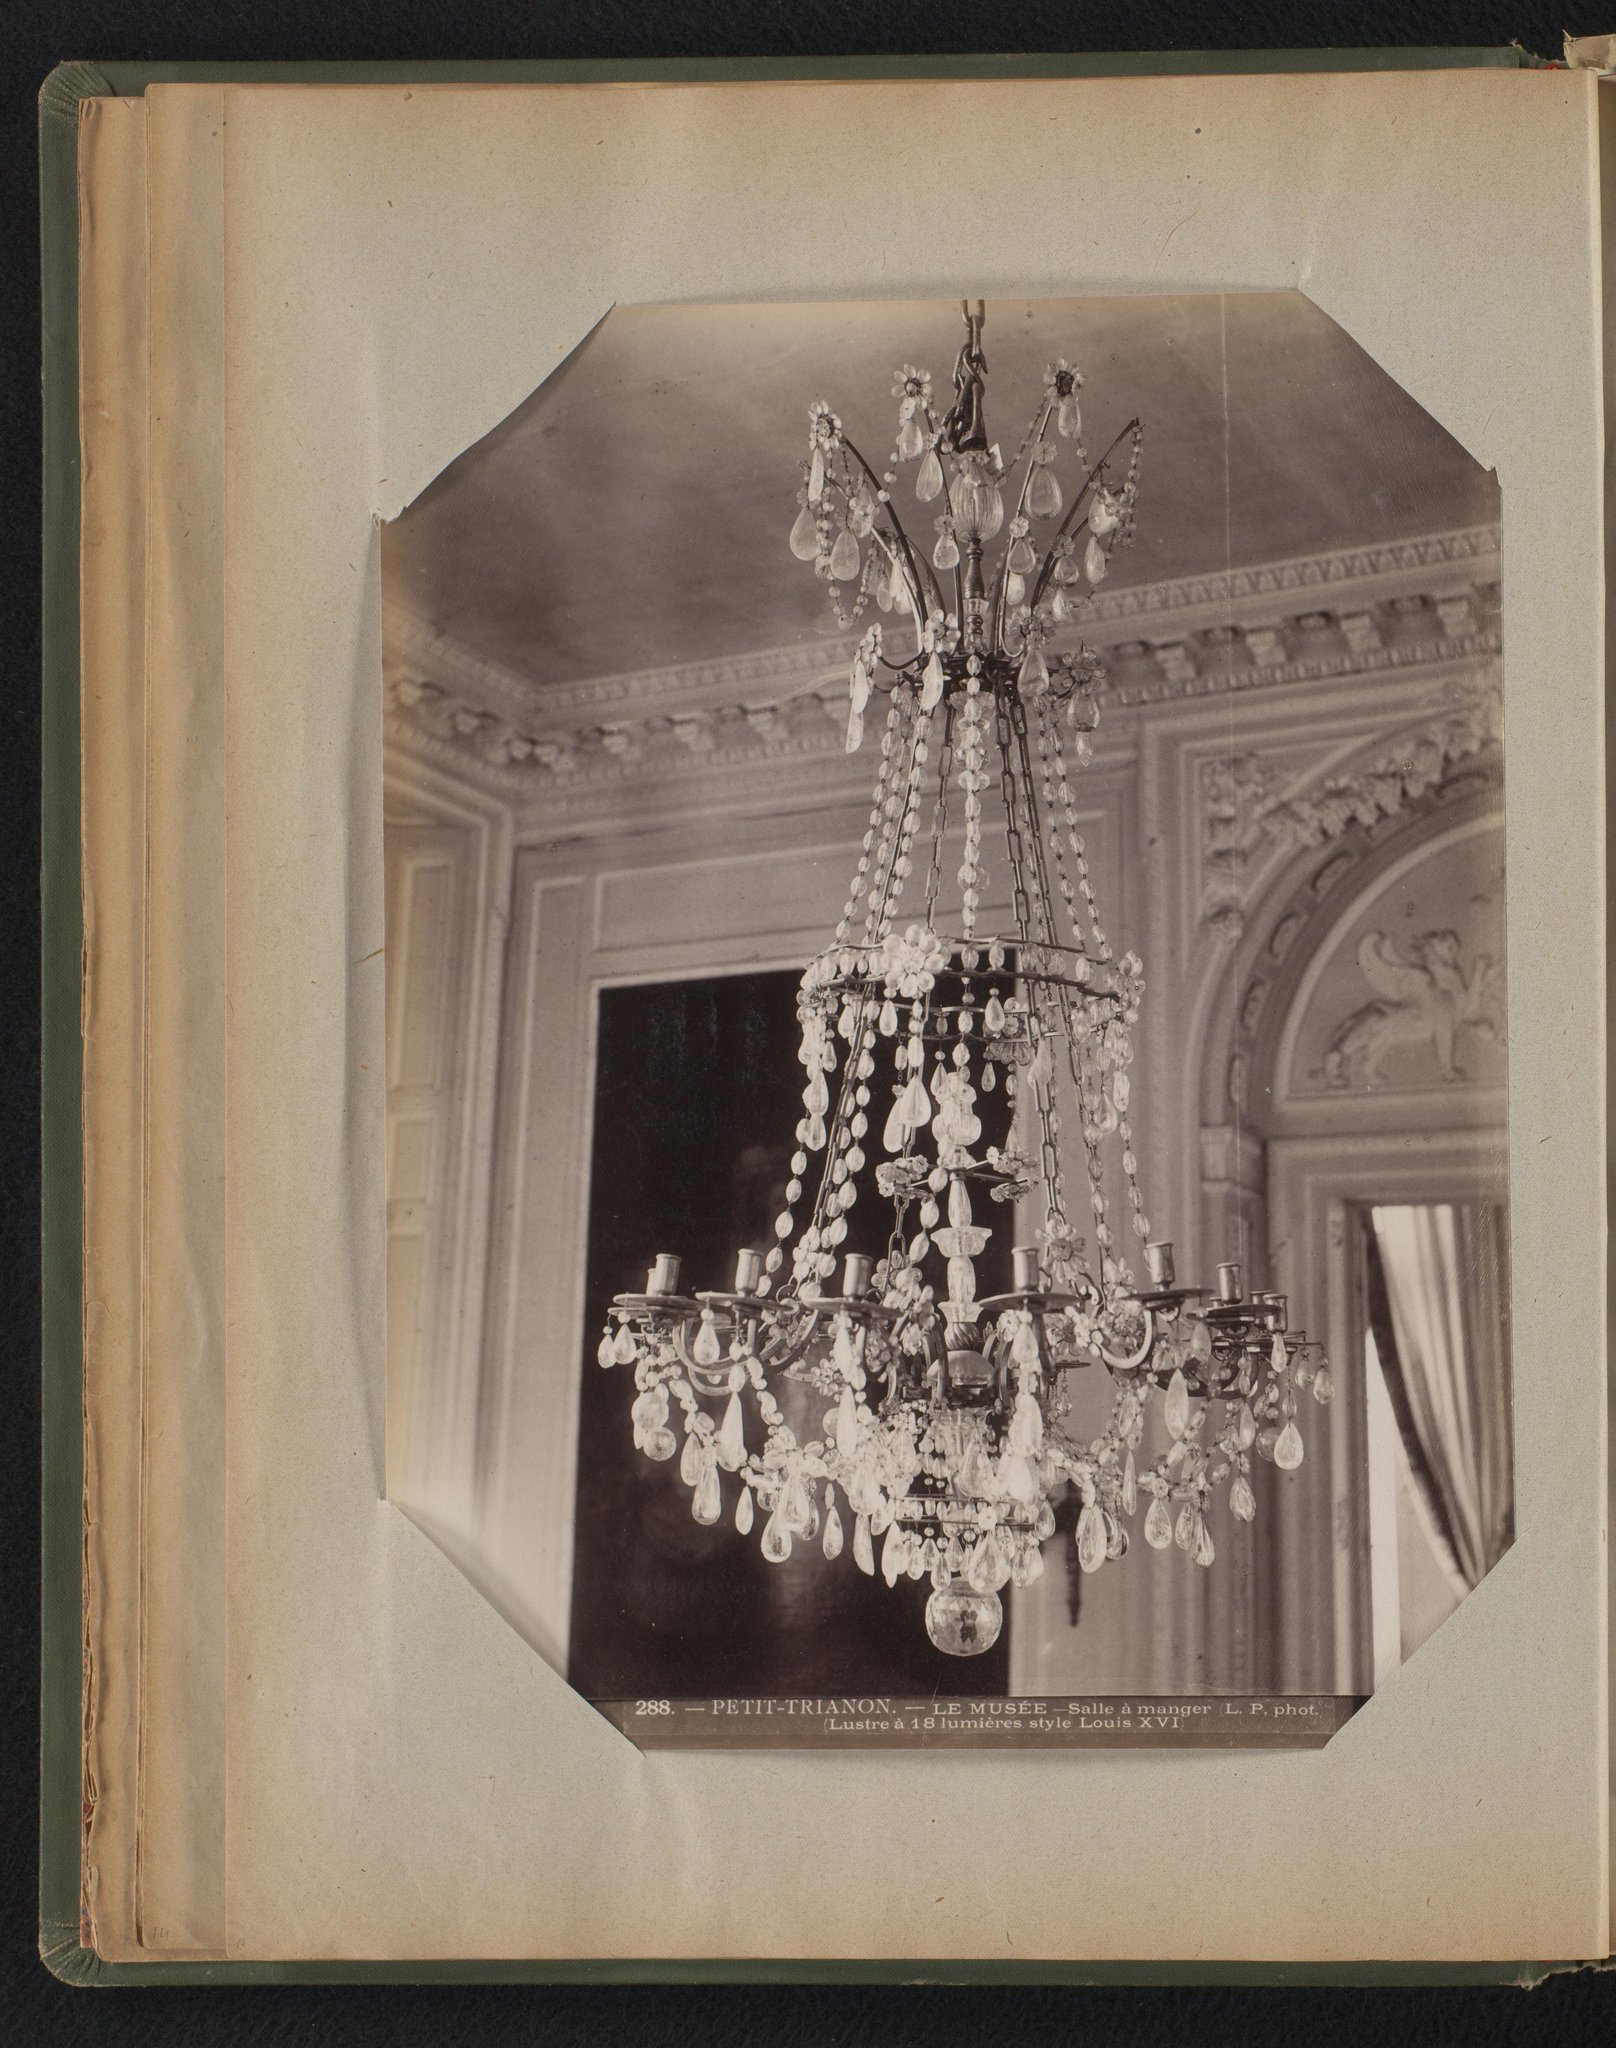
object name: photograph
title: 285. - Petit Trianon. - Le Musee - Salle a manger (L.P. Phot) (Lustre a 18 lumieres style Louis XVI).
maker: Anonymous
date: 1860-1900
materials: canvas, cardboard, paper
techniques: albumen print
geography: netherlands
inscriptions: annotation: ‘285. - Petit Trianon. - Le Musee - Salle a manger (L.P. Phot) (Lustre a 18 lumieres style Louis XVI).’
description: Onderdeel van een serie met betrekking tot het interieur van het paleis van Versailles met kroonluchters, deuren, portalen en meubelstukken.